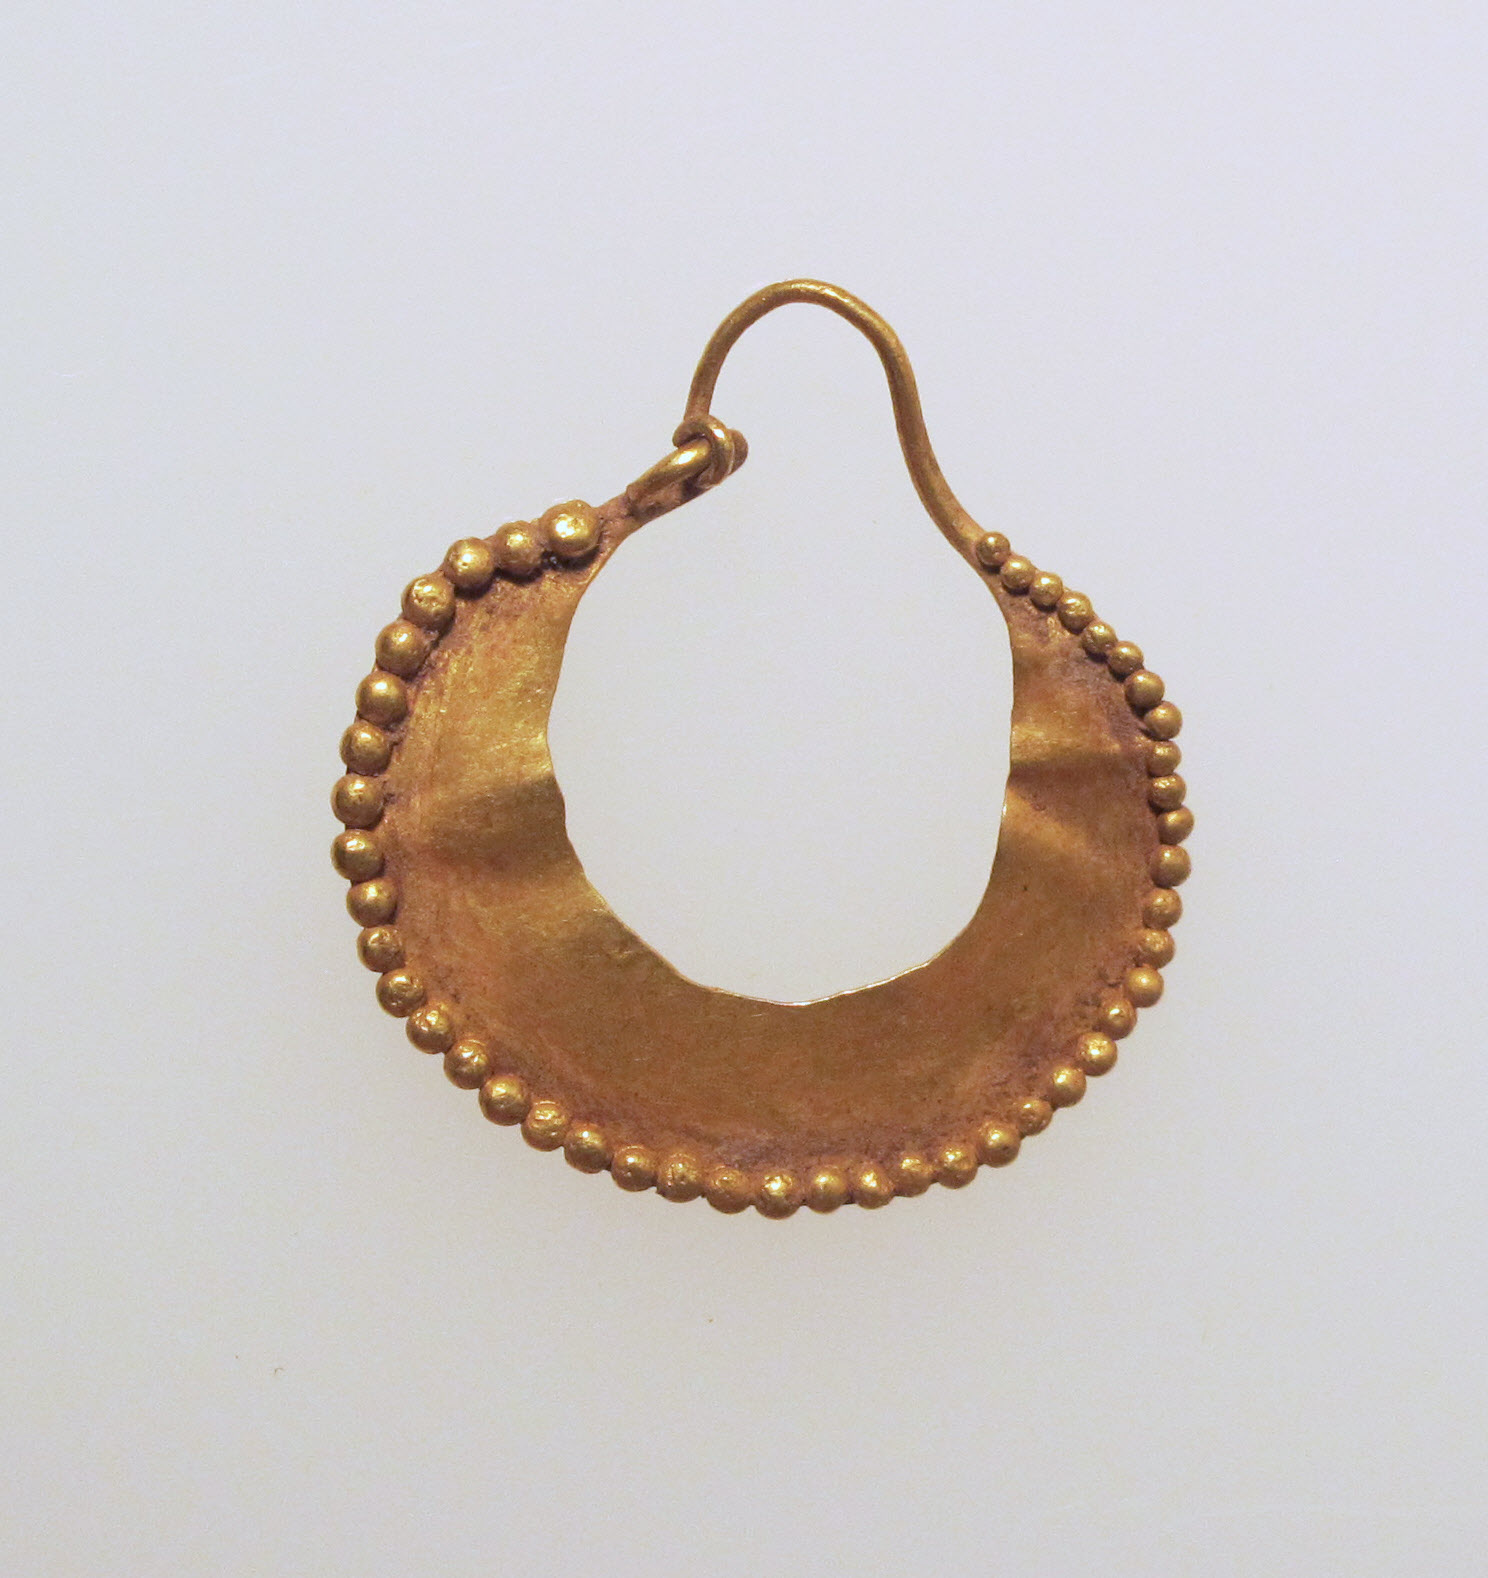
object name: earring, crescent shaped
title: Earring, crescent-shaped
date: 7000 BCE-330 CE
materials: gold